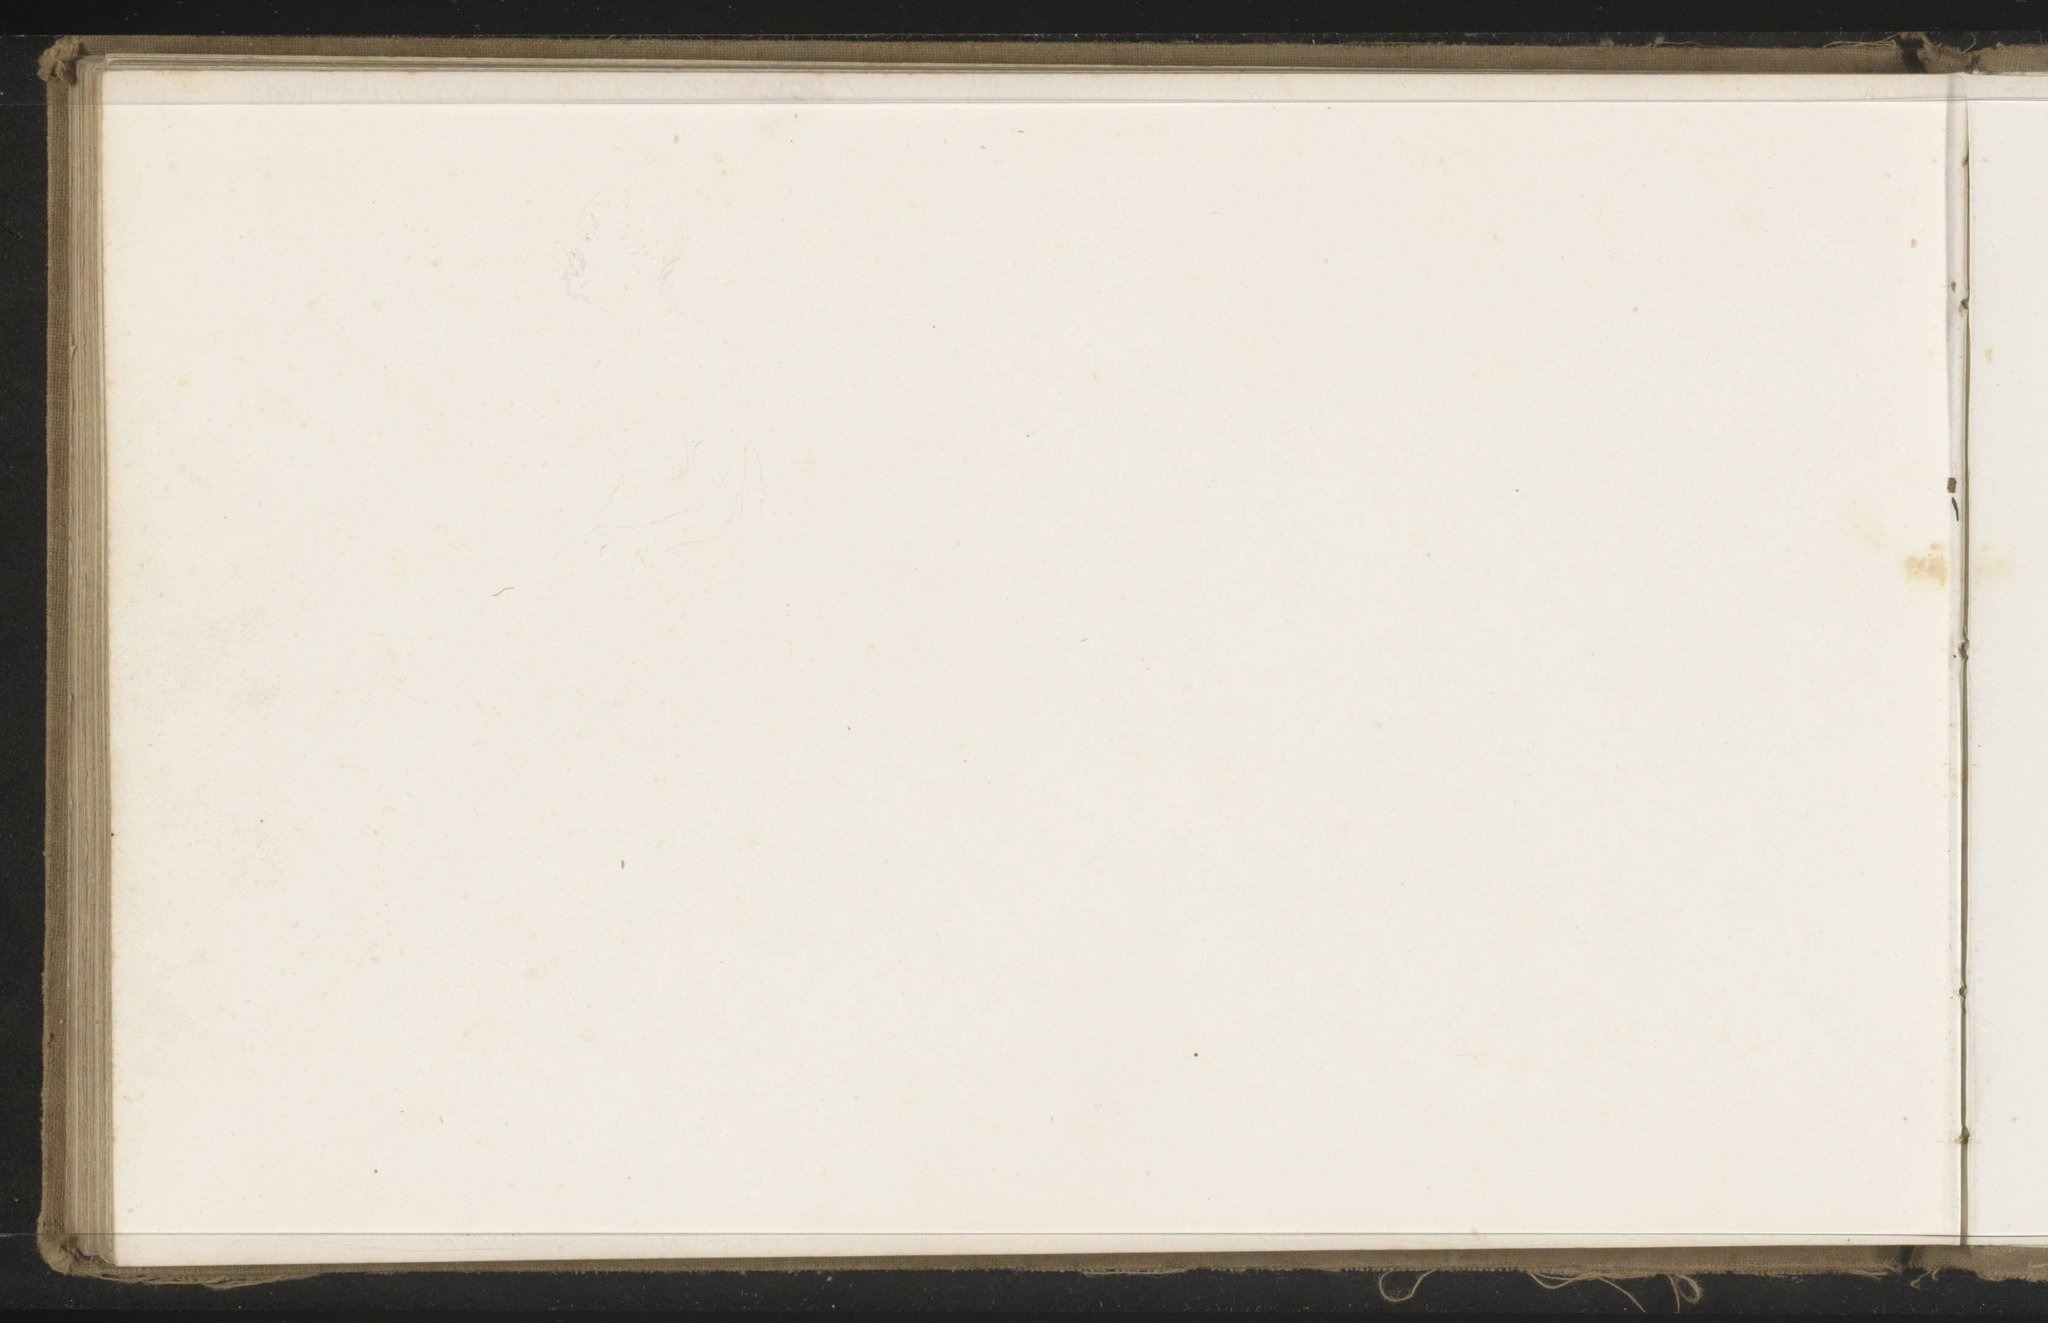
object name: sketchbook leaf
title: Man met opengesperde mond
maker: christian heinrich gottlieb steuerwald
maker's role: draughtsman, print maker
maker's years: 1802-1874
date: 1848-1854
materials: paper, pencil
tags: mouth slightly open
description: Blad 57 verso uit een schetsboek met 58 bladen.